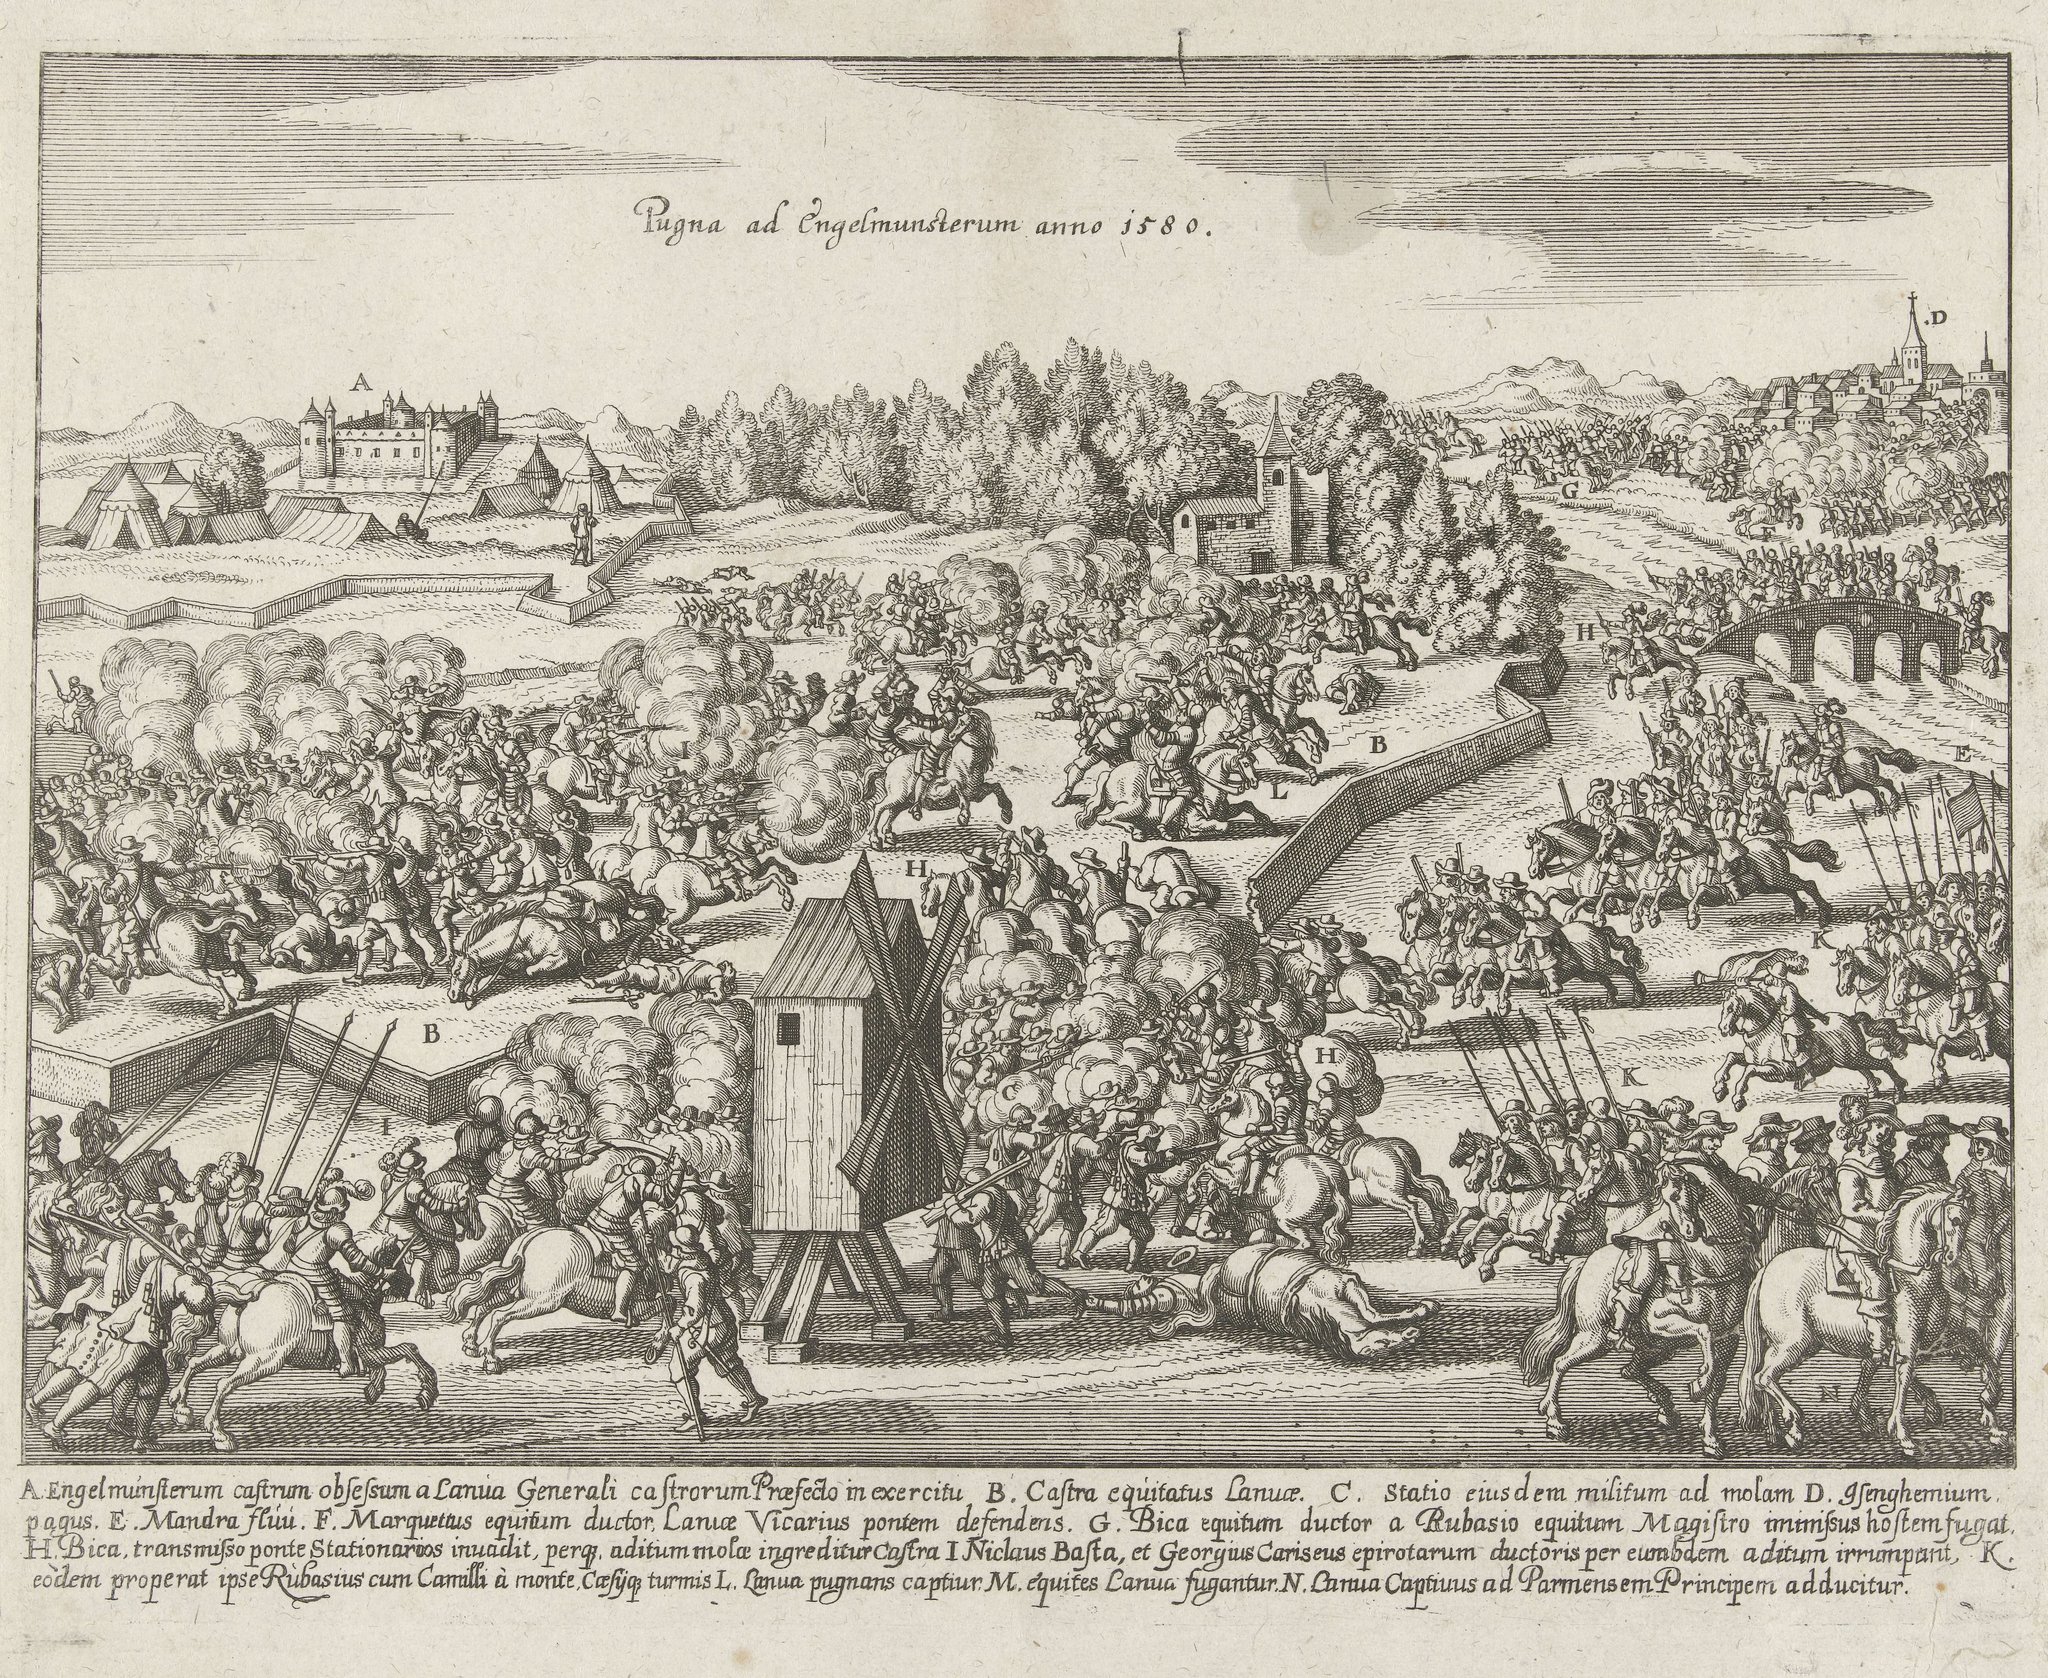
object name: print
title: Pugna ad Engelmunsterum anno 1580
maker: Anonymous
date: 1649-1651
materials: paper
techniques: etching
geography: rome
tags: battle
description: Kopie naar de illustratie in: F. Strada, De Bello belgico decades duae auctiores et correctiores cum figuris encis prodeunt a Famiano Strada Soc: Jesu Romano Moguntiae 1651. Kopie naar de onbekende prent uit de oorspronkelijke editie van 1647.